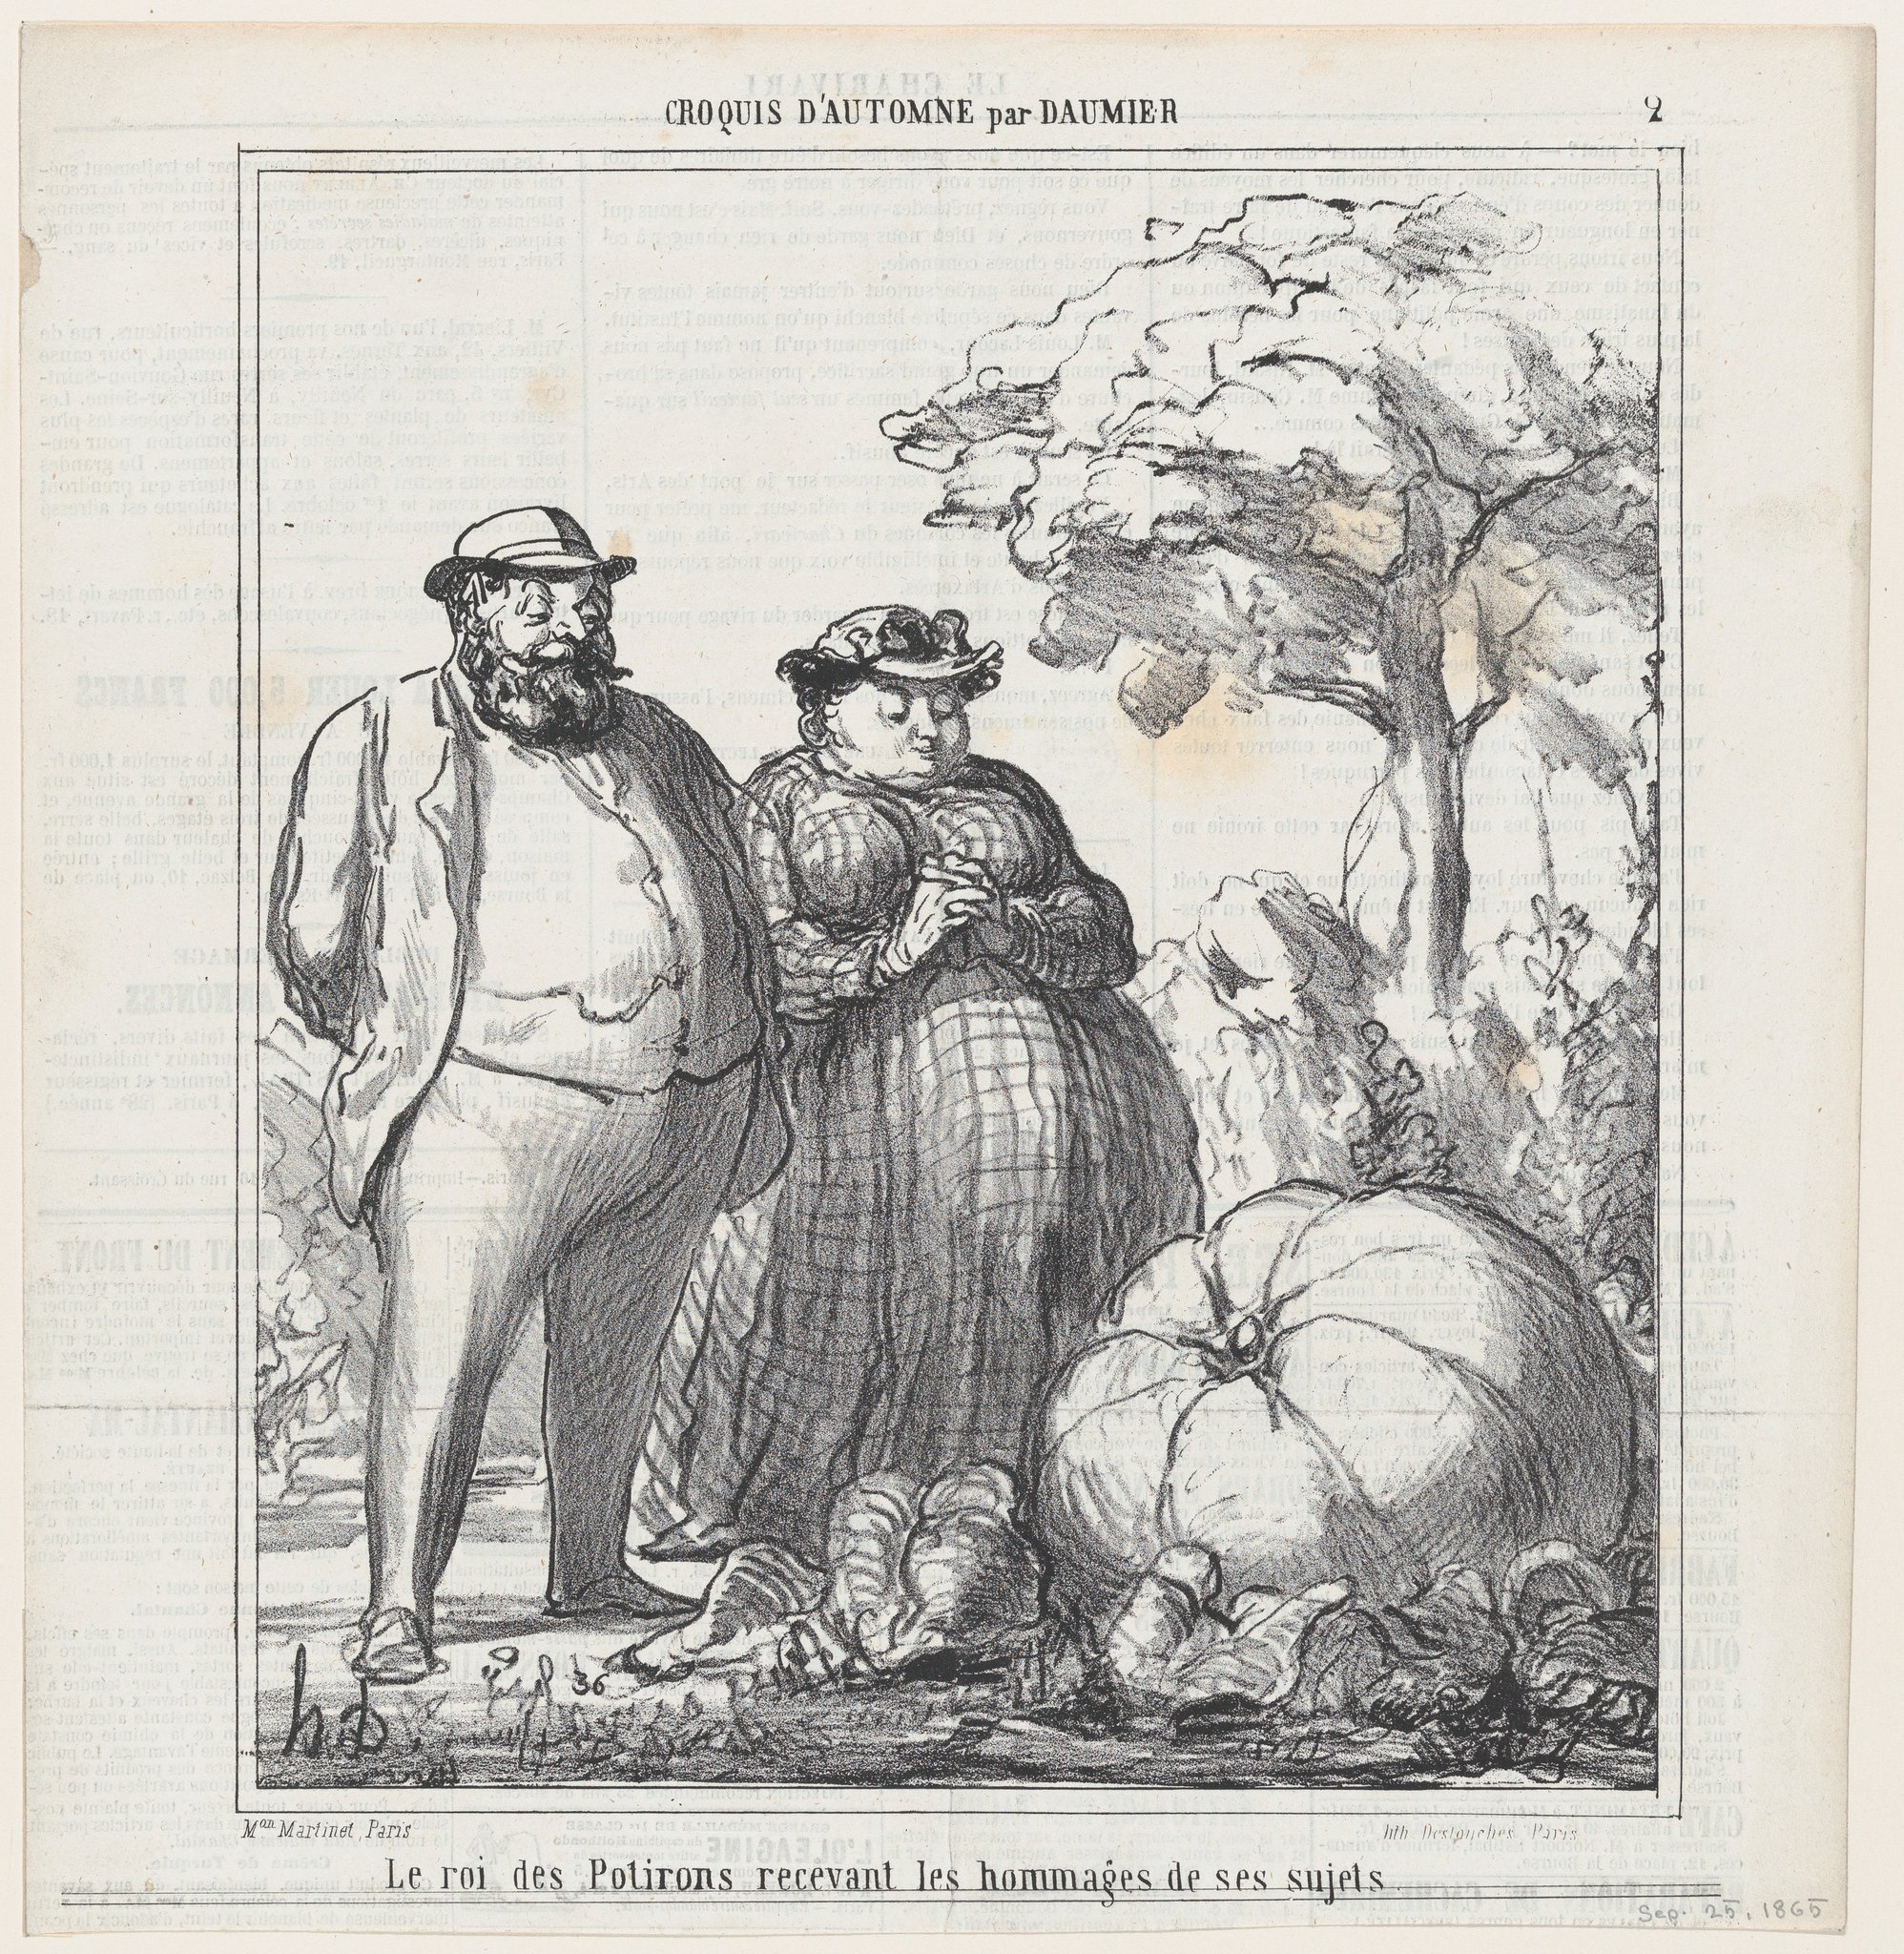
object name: print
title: The king of pumpkins receiving the homage of his subjects, from 'Autumn sketches,' published in Le Charivari, September 23, 1865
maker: honoré daumier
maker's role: artist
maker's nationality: french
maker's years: 1808-1879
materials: paper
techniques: lithograph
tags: vegetables,men,women